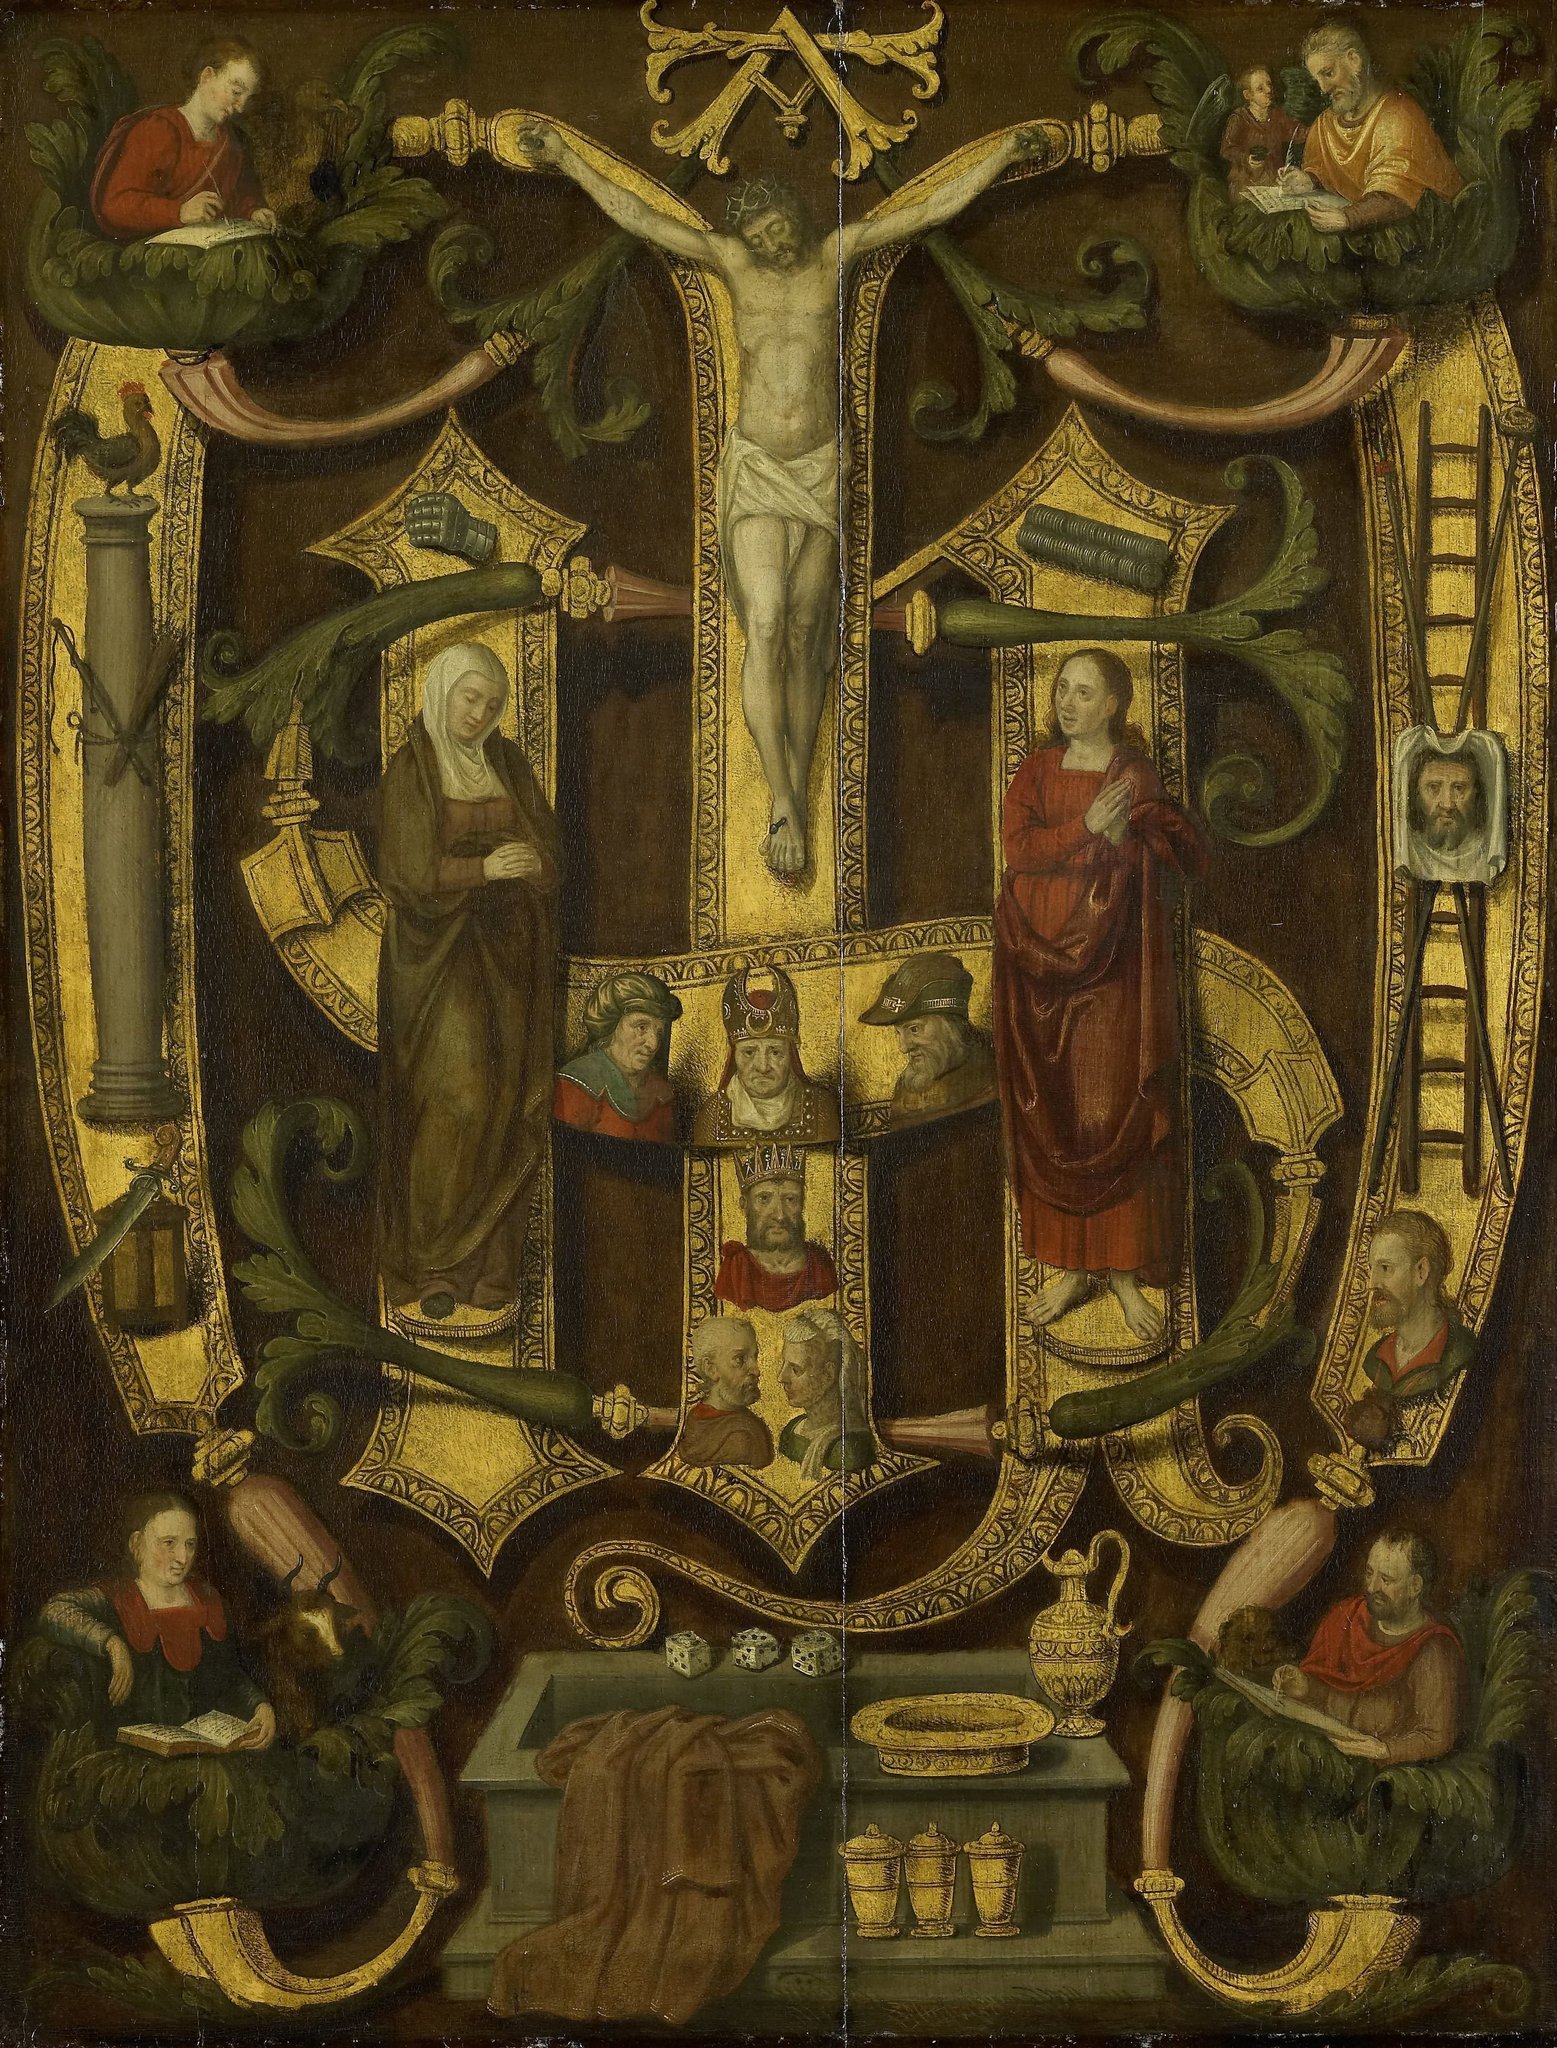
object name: painting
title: Monogram of Christ combined with Instruments of the Passion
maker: Anonymous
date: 1560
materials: oil, panel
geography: southern netherlands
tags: ihs ('iesus hominum salvator') ~ symbol of christ, 'arma christi'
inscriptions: inscription: ‘Non est aliud nomen sub caelo datum hominibus In quo oporteat nos salvos fieri. Act 4 capite’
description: De Arma Christi. Het monogram van Christus gecombineerd met de passiewerktuigen.